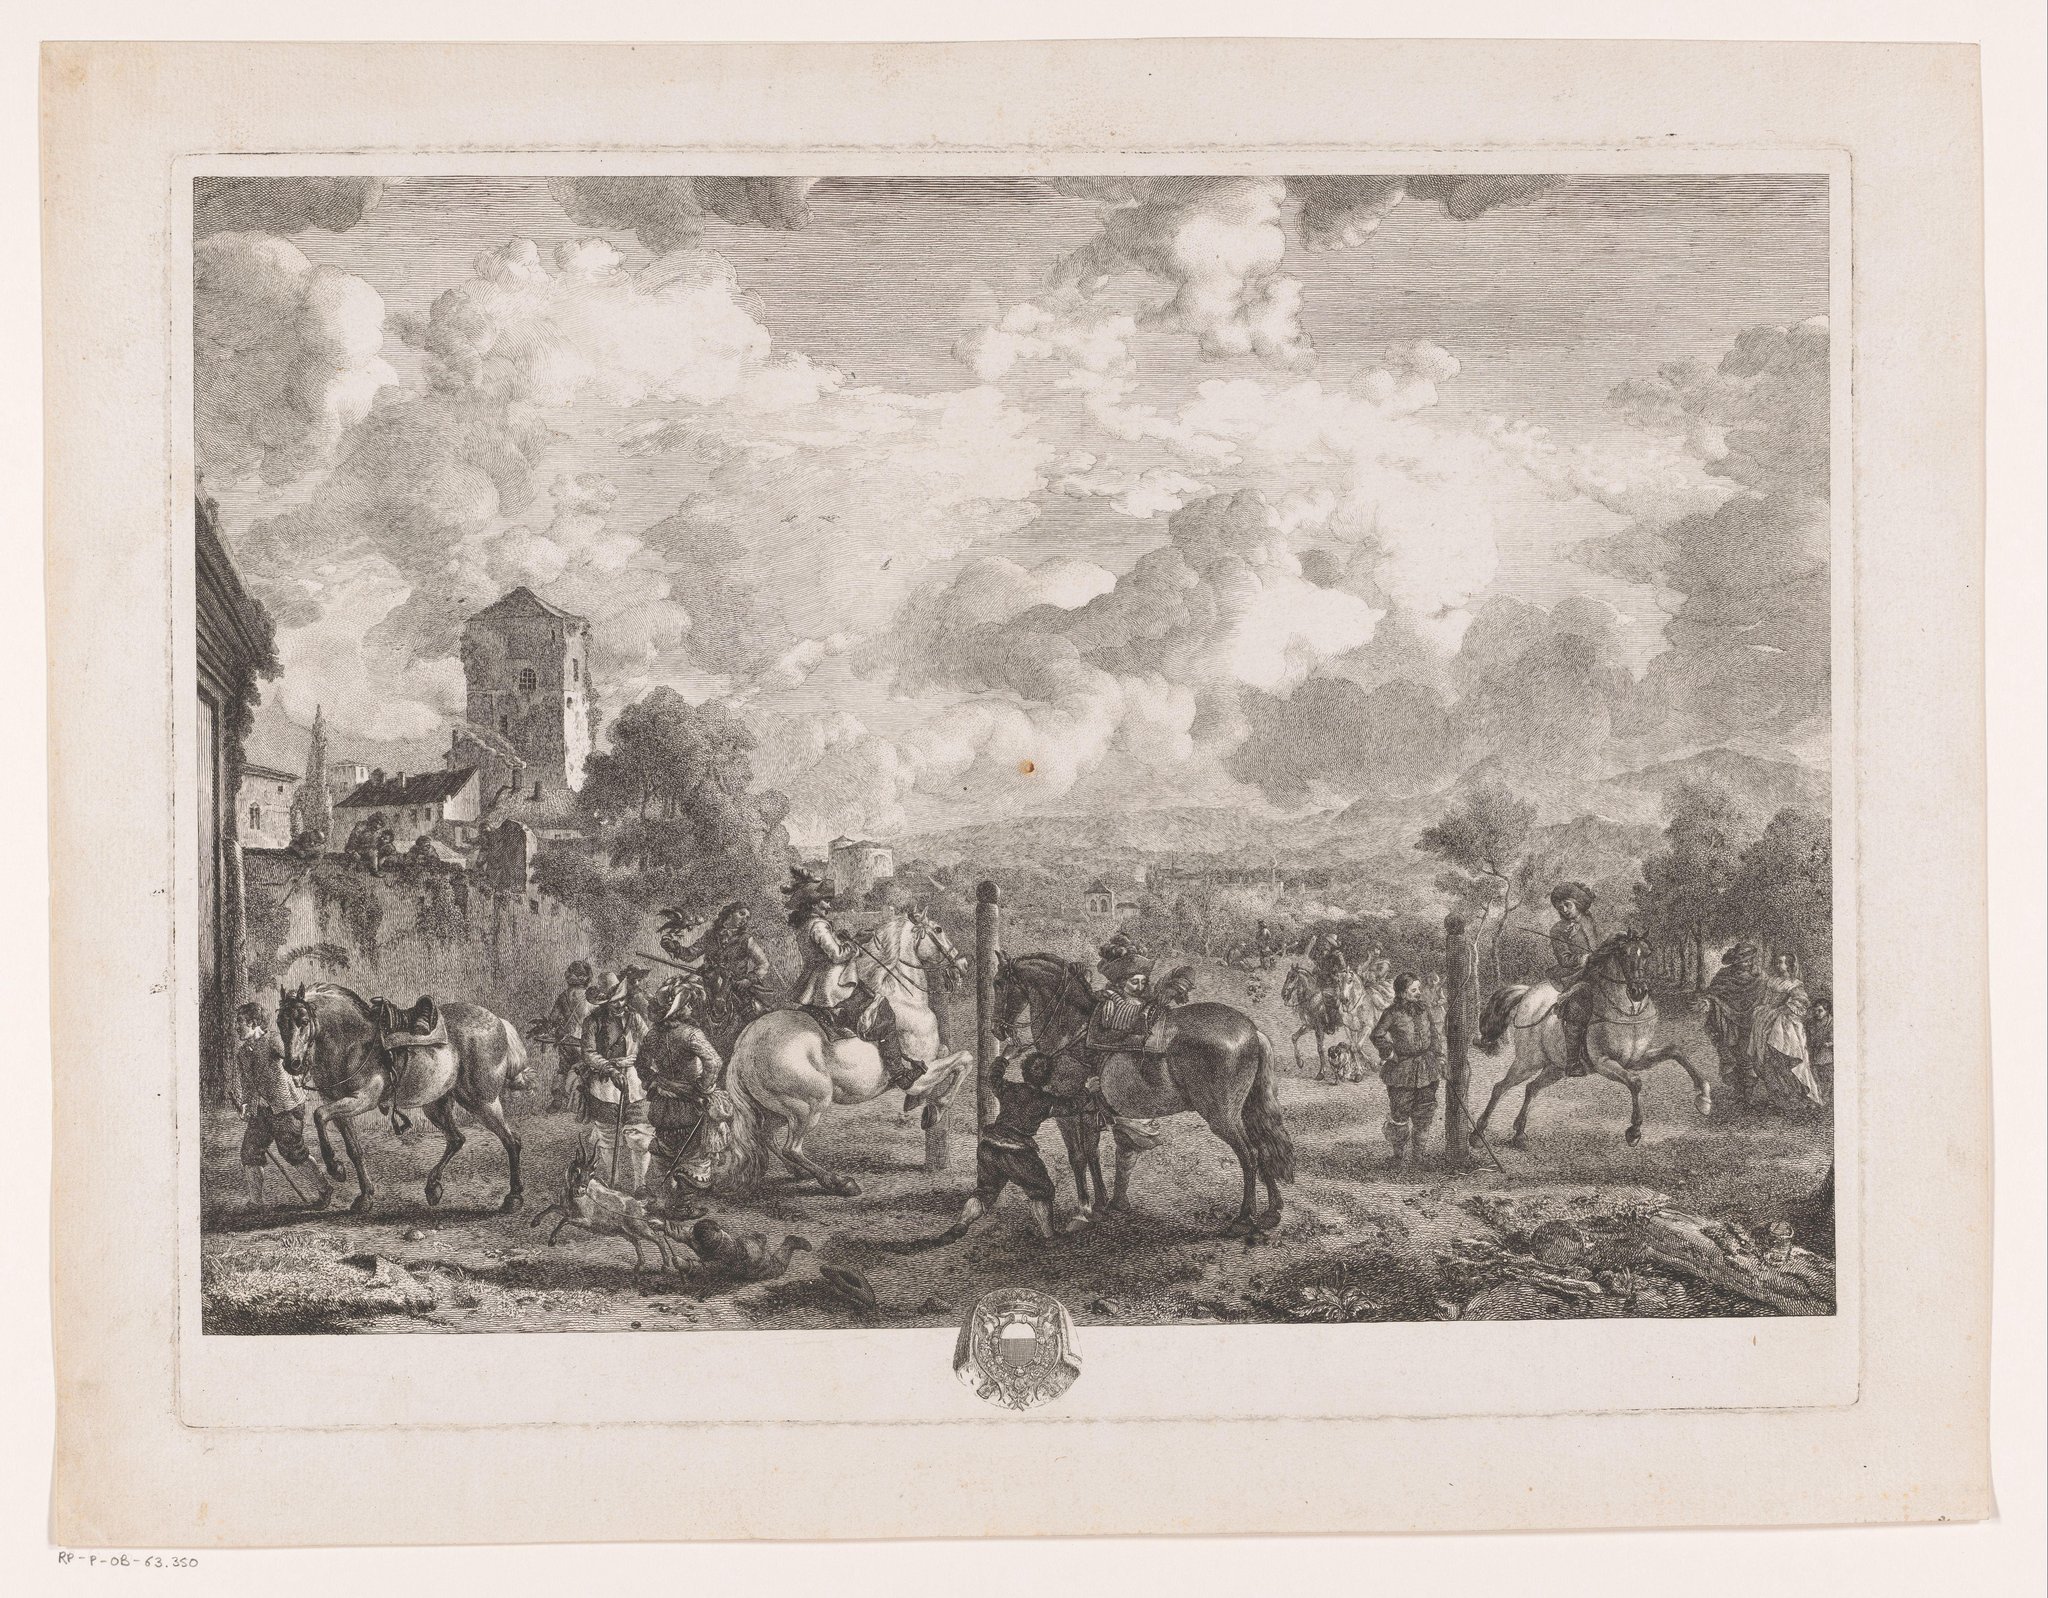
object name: print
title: Oeuvres de Ph.pe Wouwermans Hollandois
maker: jean moyreau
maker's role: print maker, publisher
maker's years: 1690-1762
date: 1742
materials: paper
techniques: engraving, etching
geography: france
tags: riding-school, manège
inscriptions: collector's mark: Lugt 240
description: Maakt deel uit van een serie van 89 prenten te dateren tussen ca. 1733-1762, naar het geschilderde oeuvre van Philips Wouwerman. Dit betreft plaat 43.